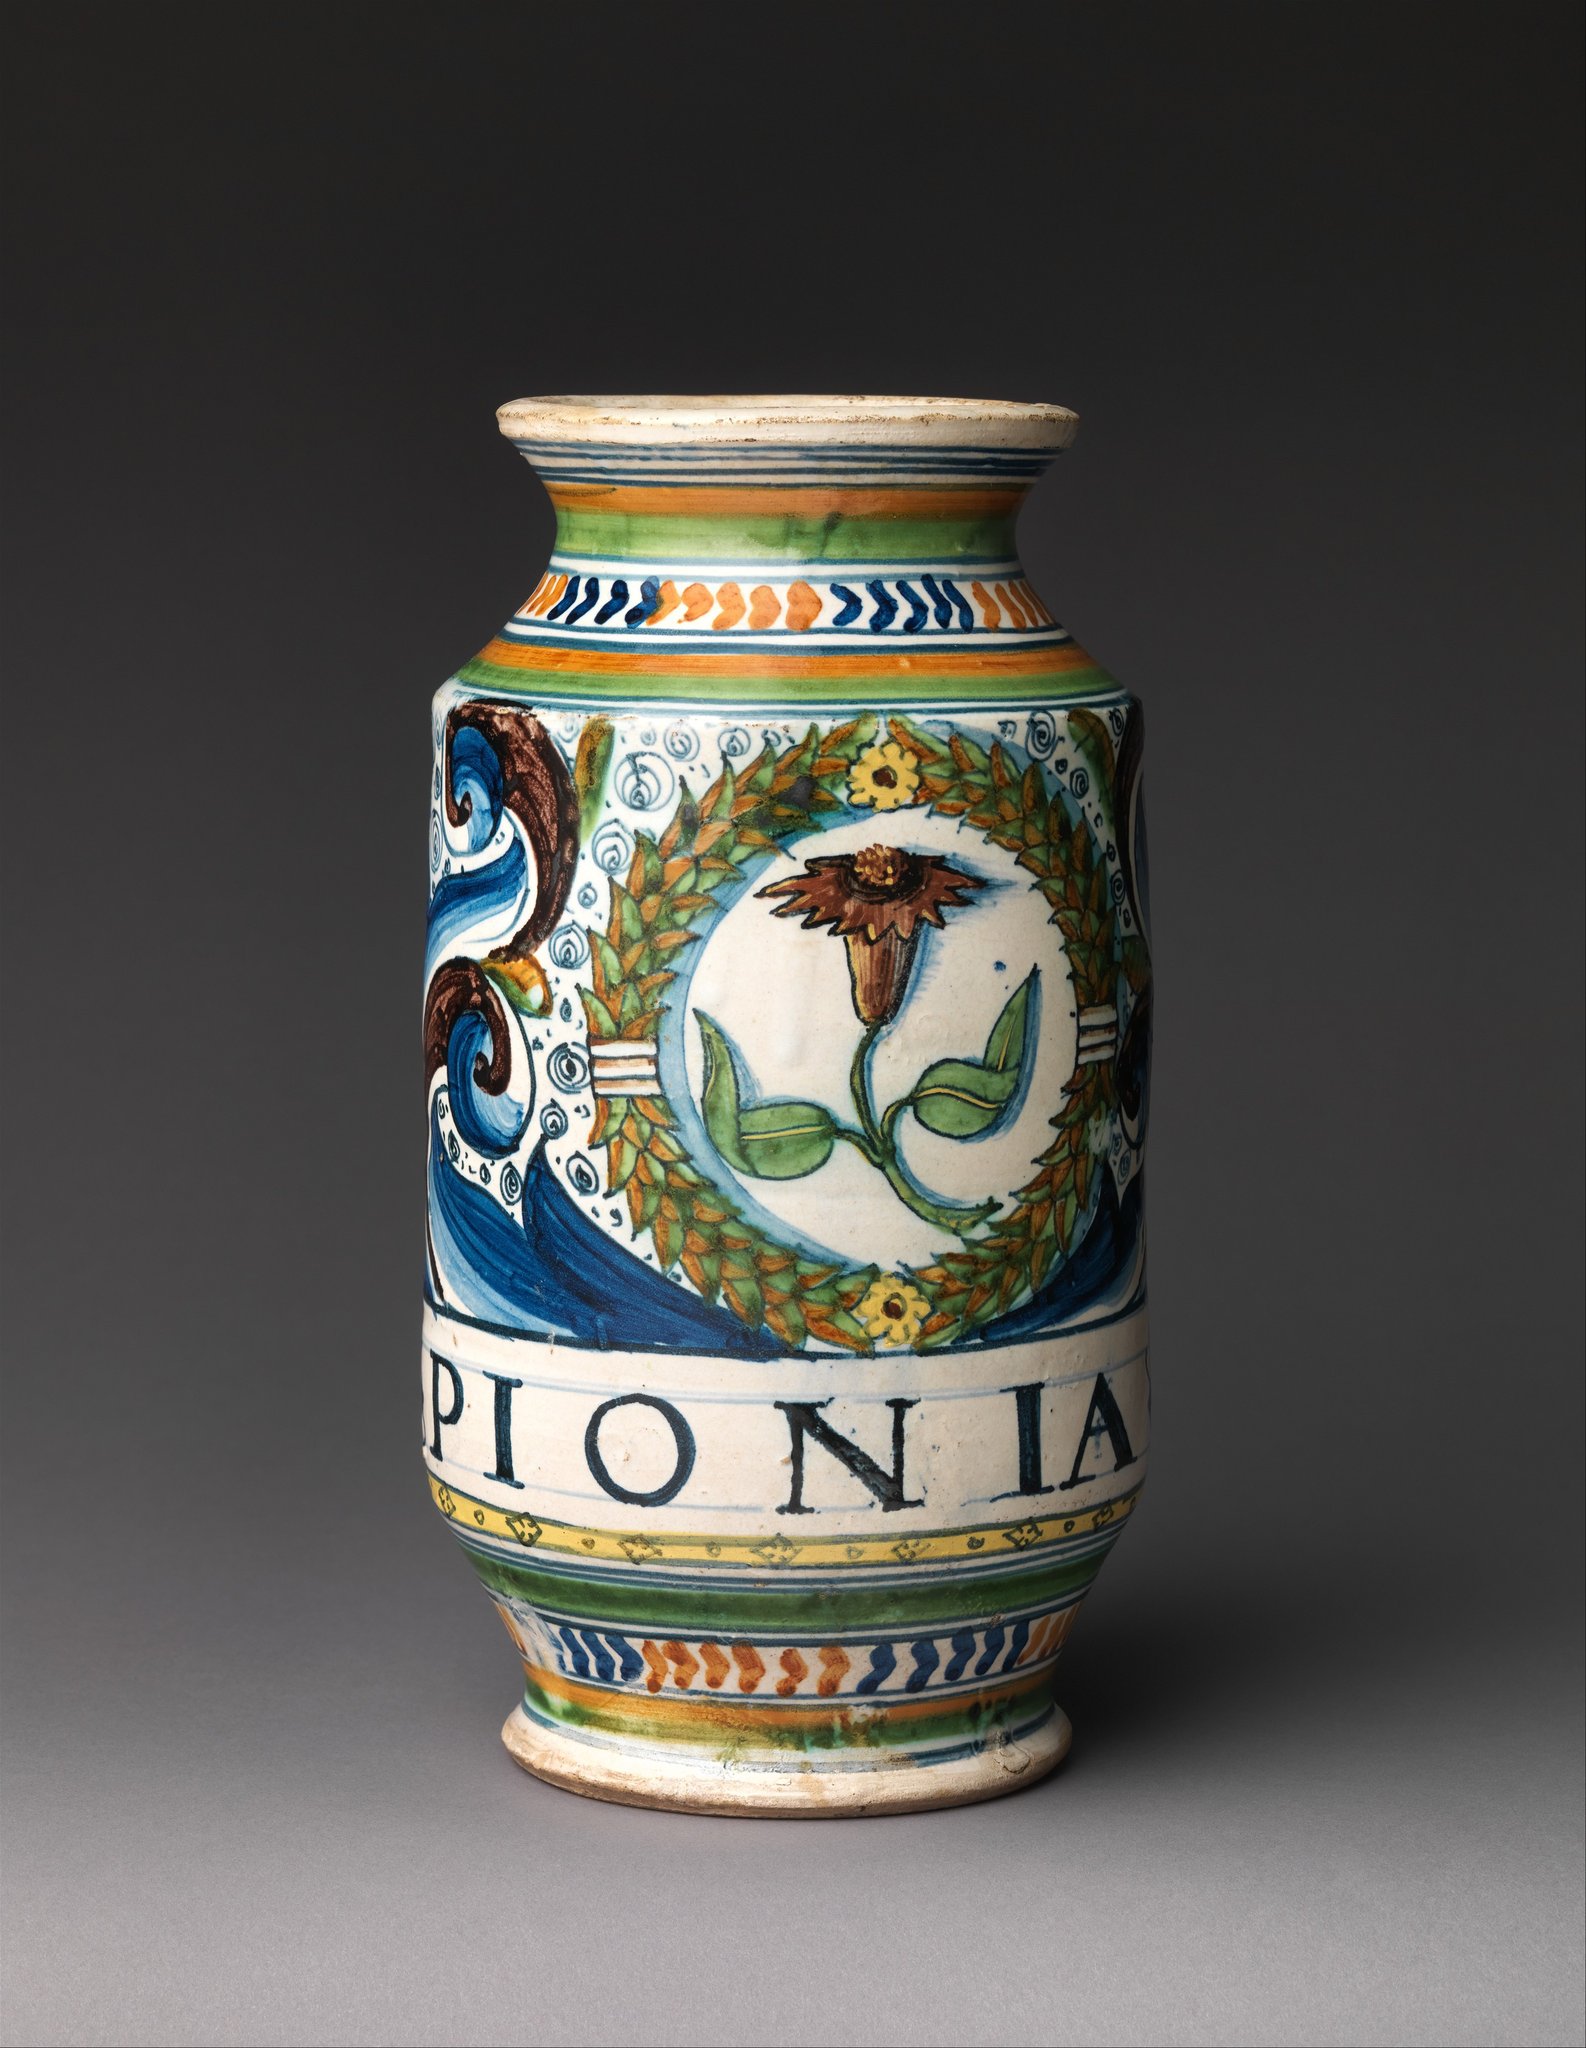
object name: pharmacy jar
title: Pharmacy jar (albarello)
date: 1500-1510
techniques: maiolica, glazing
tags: flowers